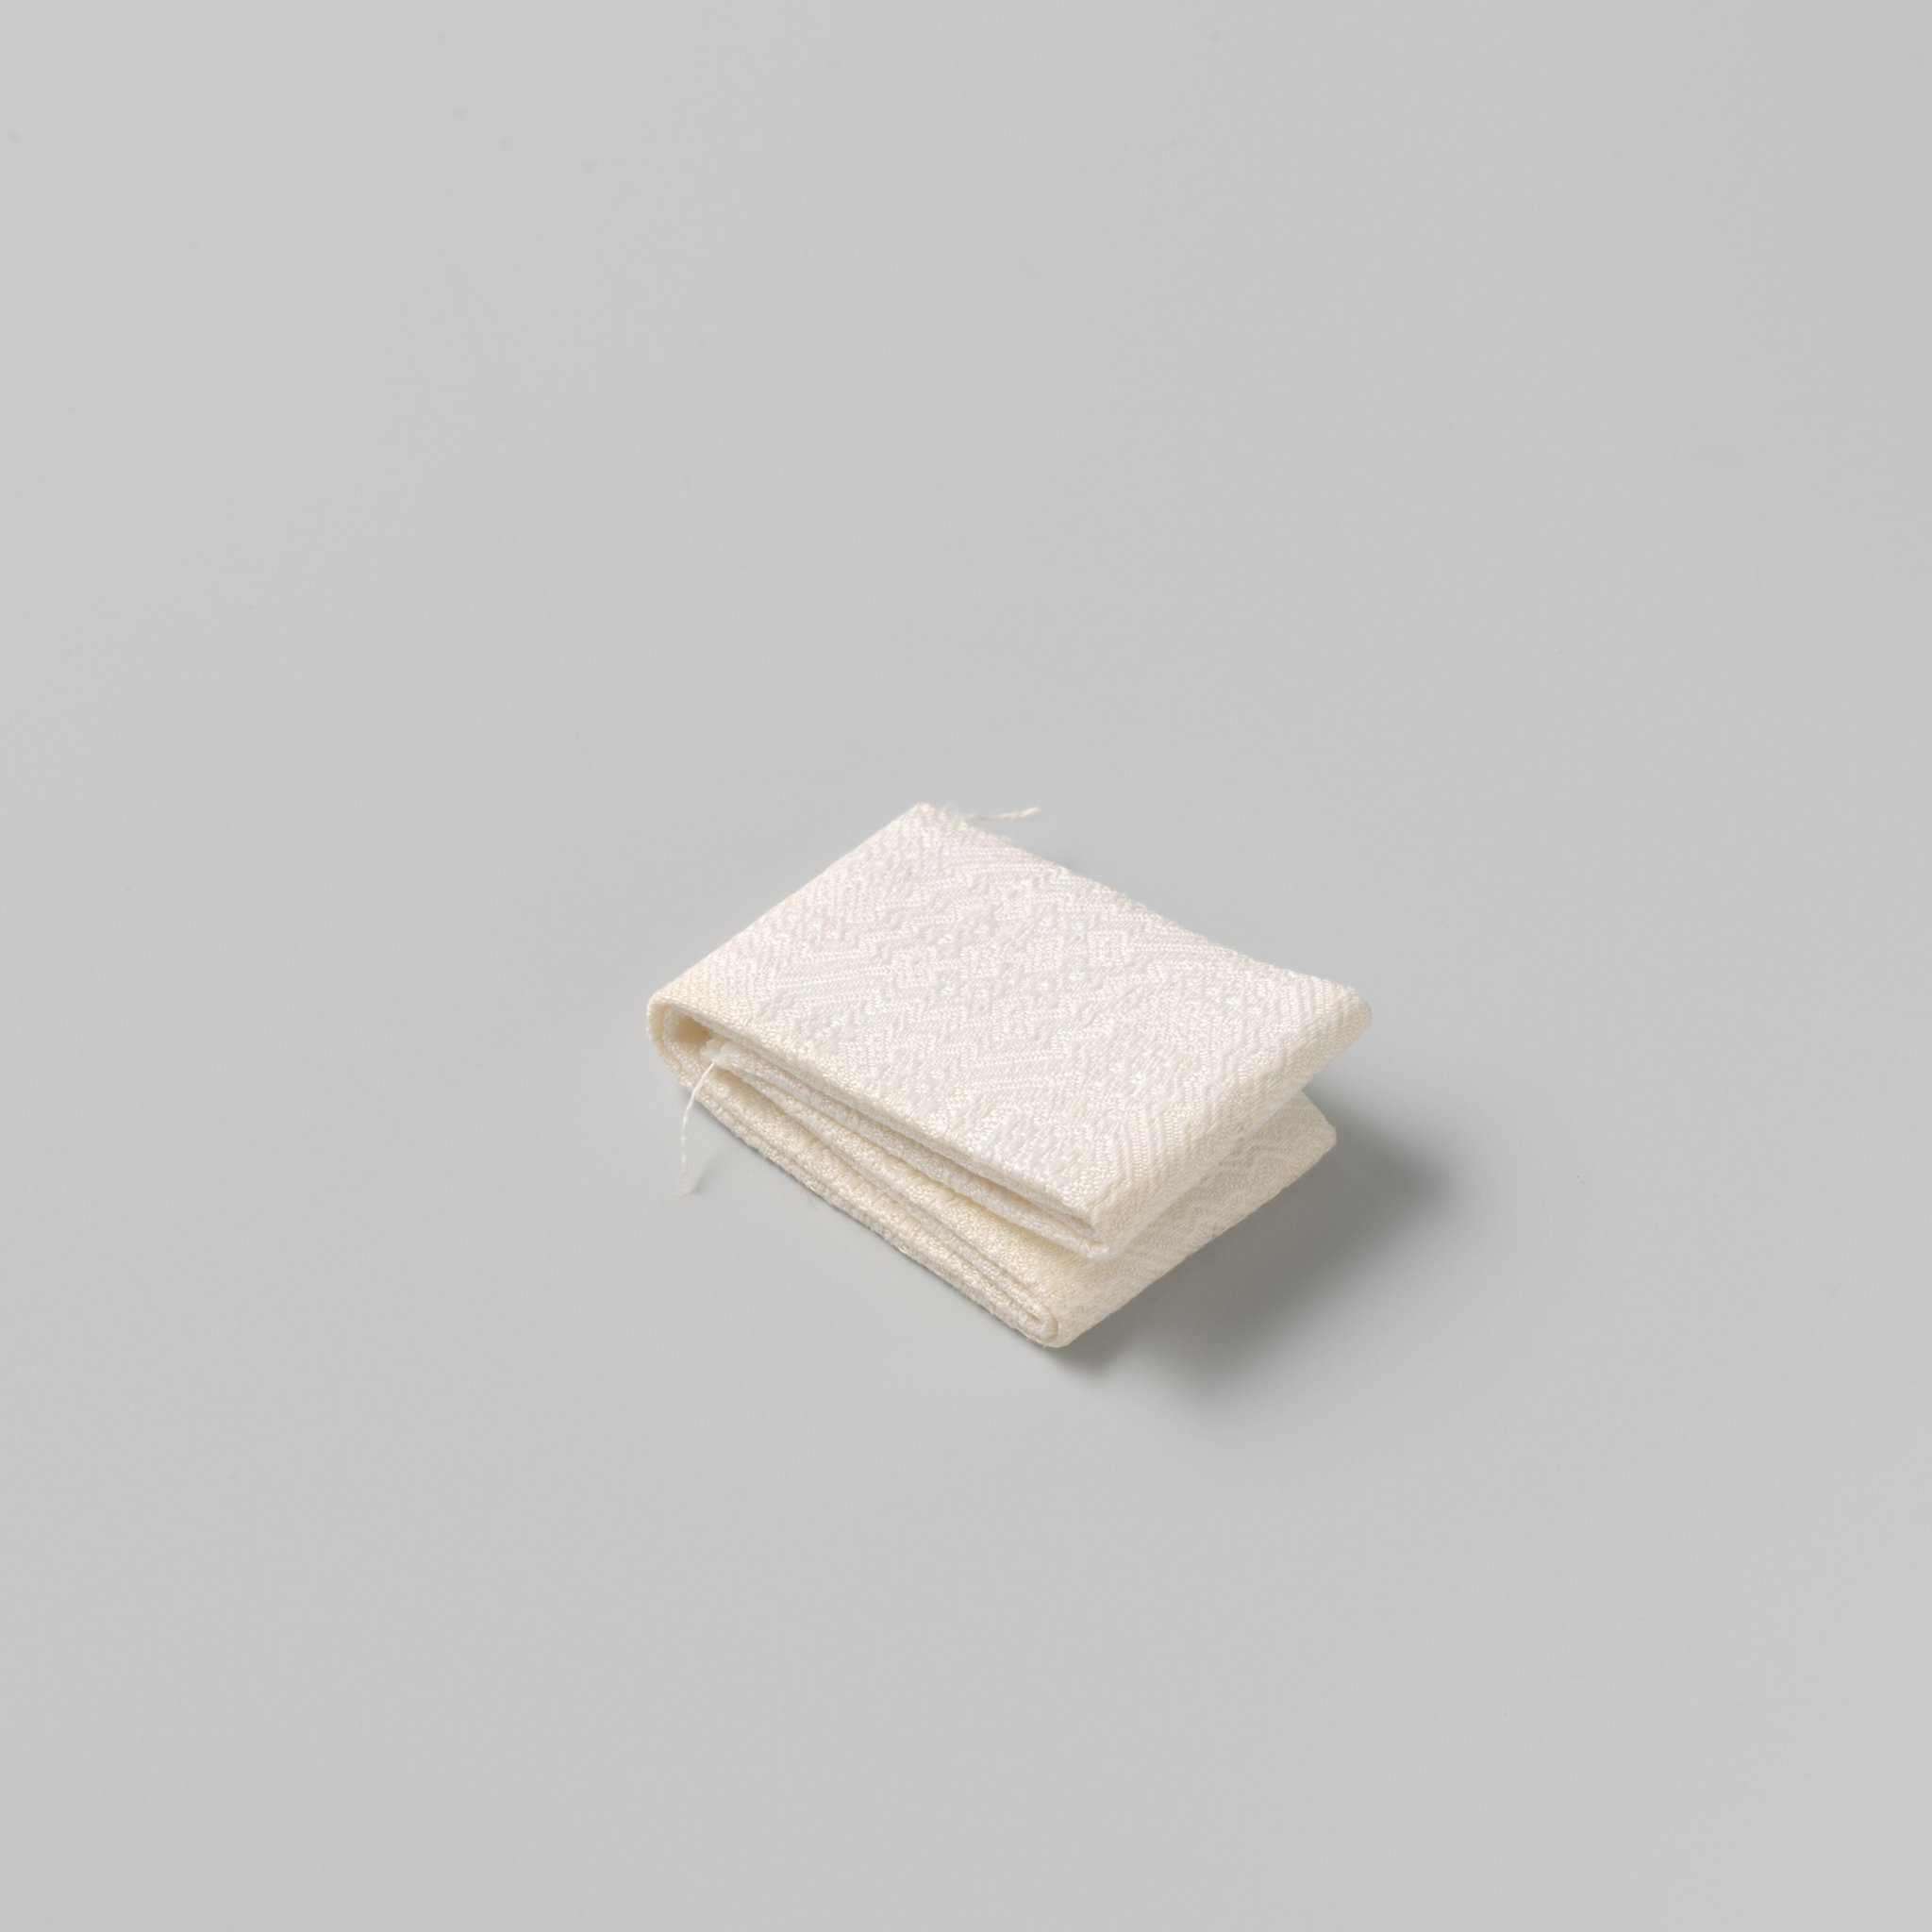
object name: miniature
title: Servet, damastweefsel met een pellenpatroon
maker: Anonymous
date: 1600-1699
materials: linen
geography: netherlands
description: Servet, damastweefsel met pellenpatroon, geknipt uit een groter stuk linnen, niet omgezoomd.